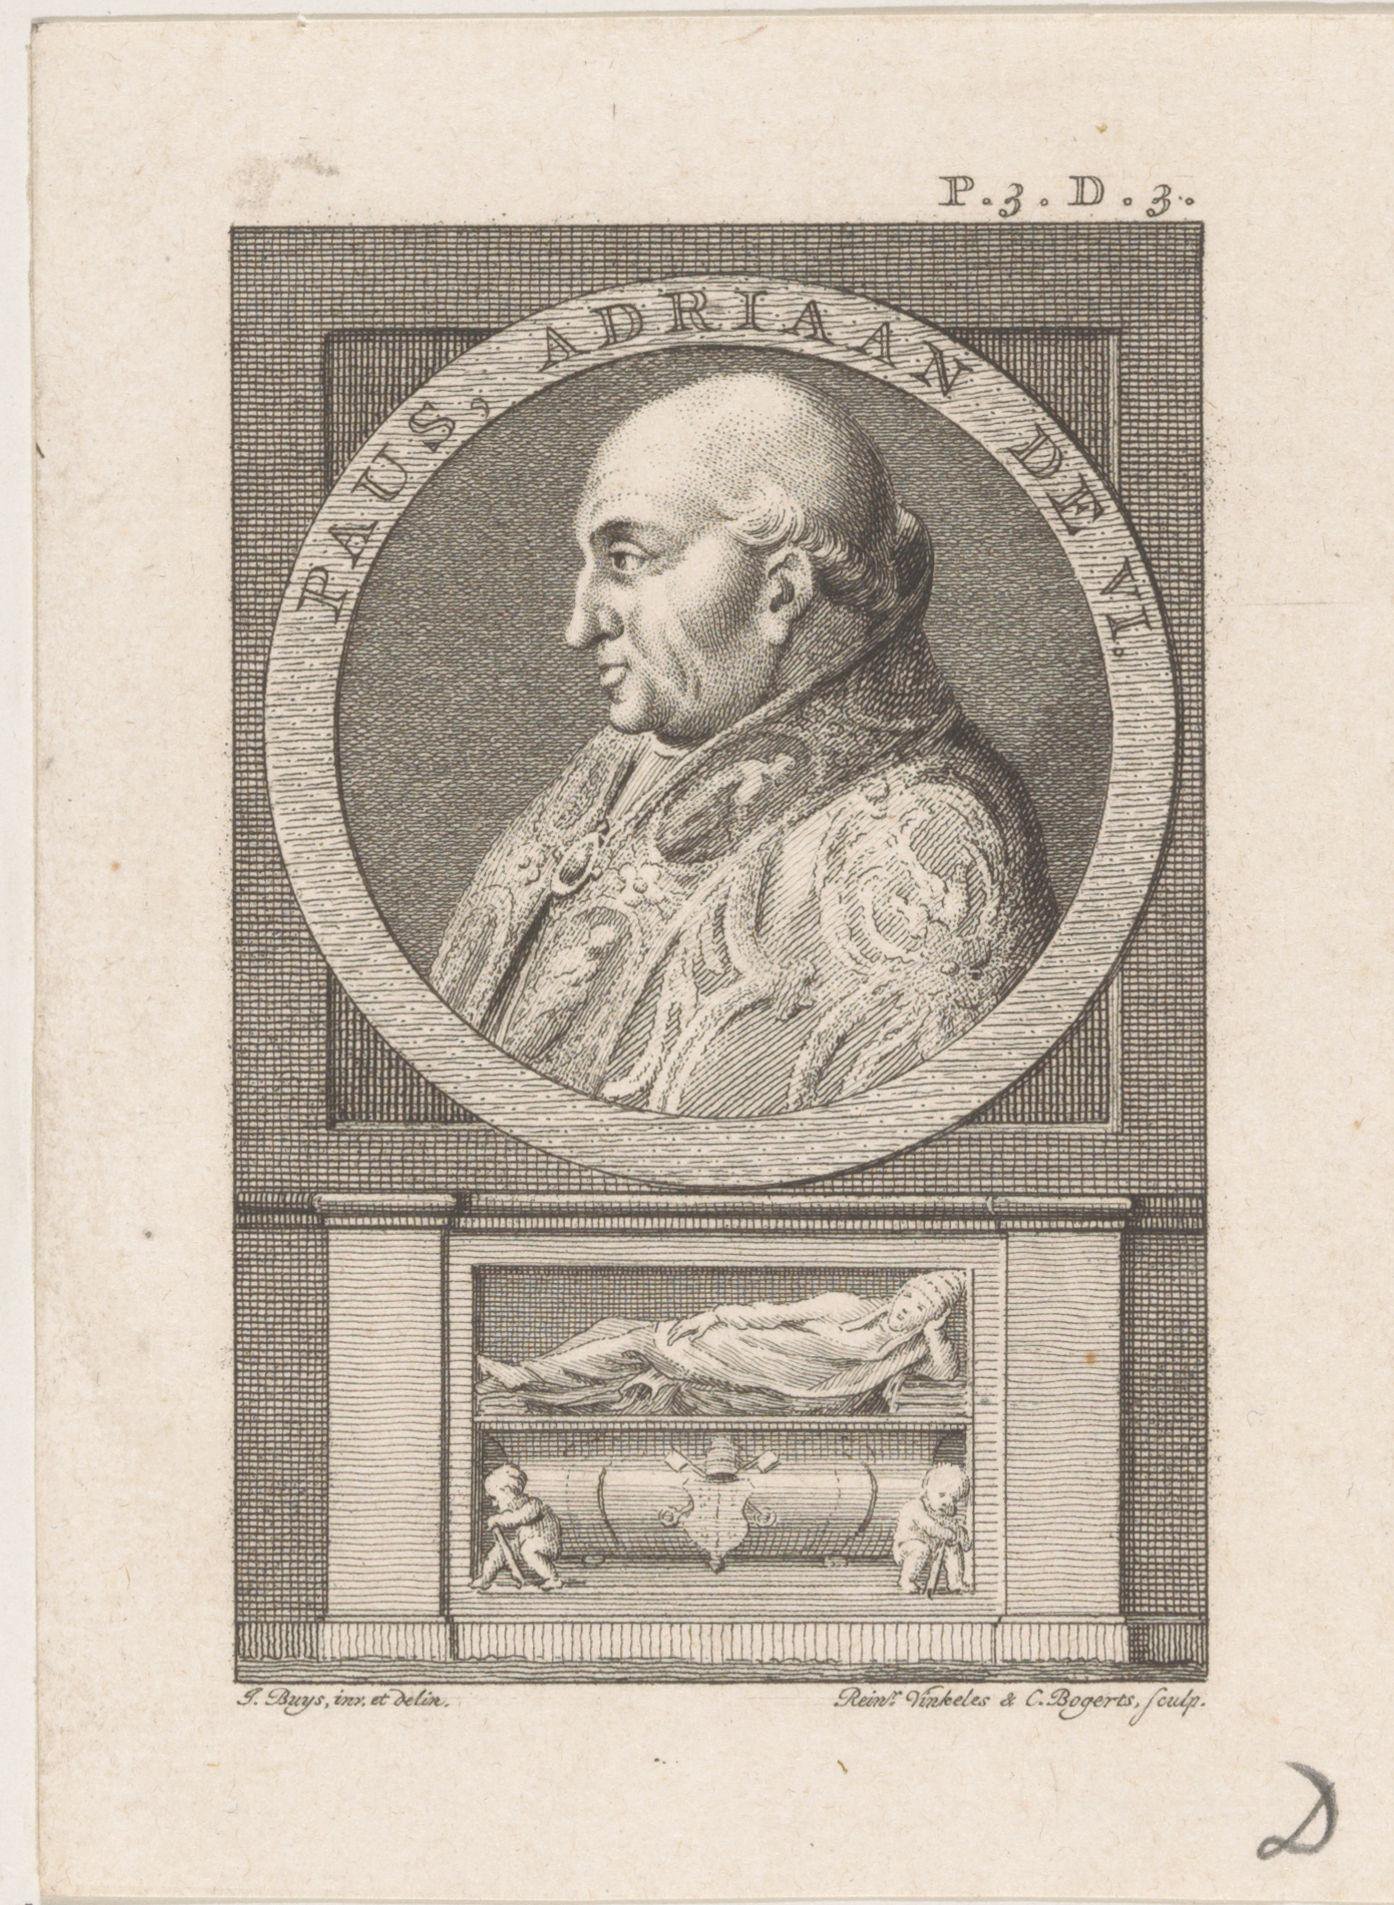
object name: print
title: Portret van paus Adrianus VI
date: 1771-1816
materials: paper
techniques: engraving, etching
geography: amsterdam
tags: utrecht, clergyman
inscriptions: collector's mark: Lugt 2228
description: Portret van paus Adrianus VI in een cirkelvormige omlijsting met randschrift. In een kader een voorstelling van zijn tombe. Rechtsboven: P.3. D.3.